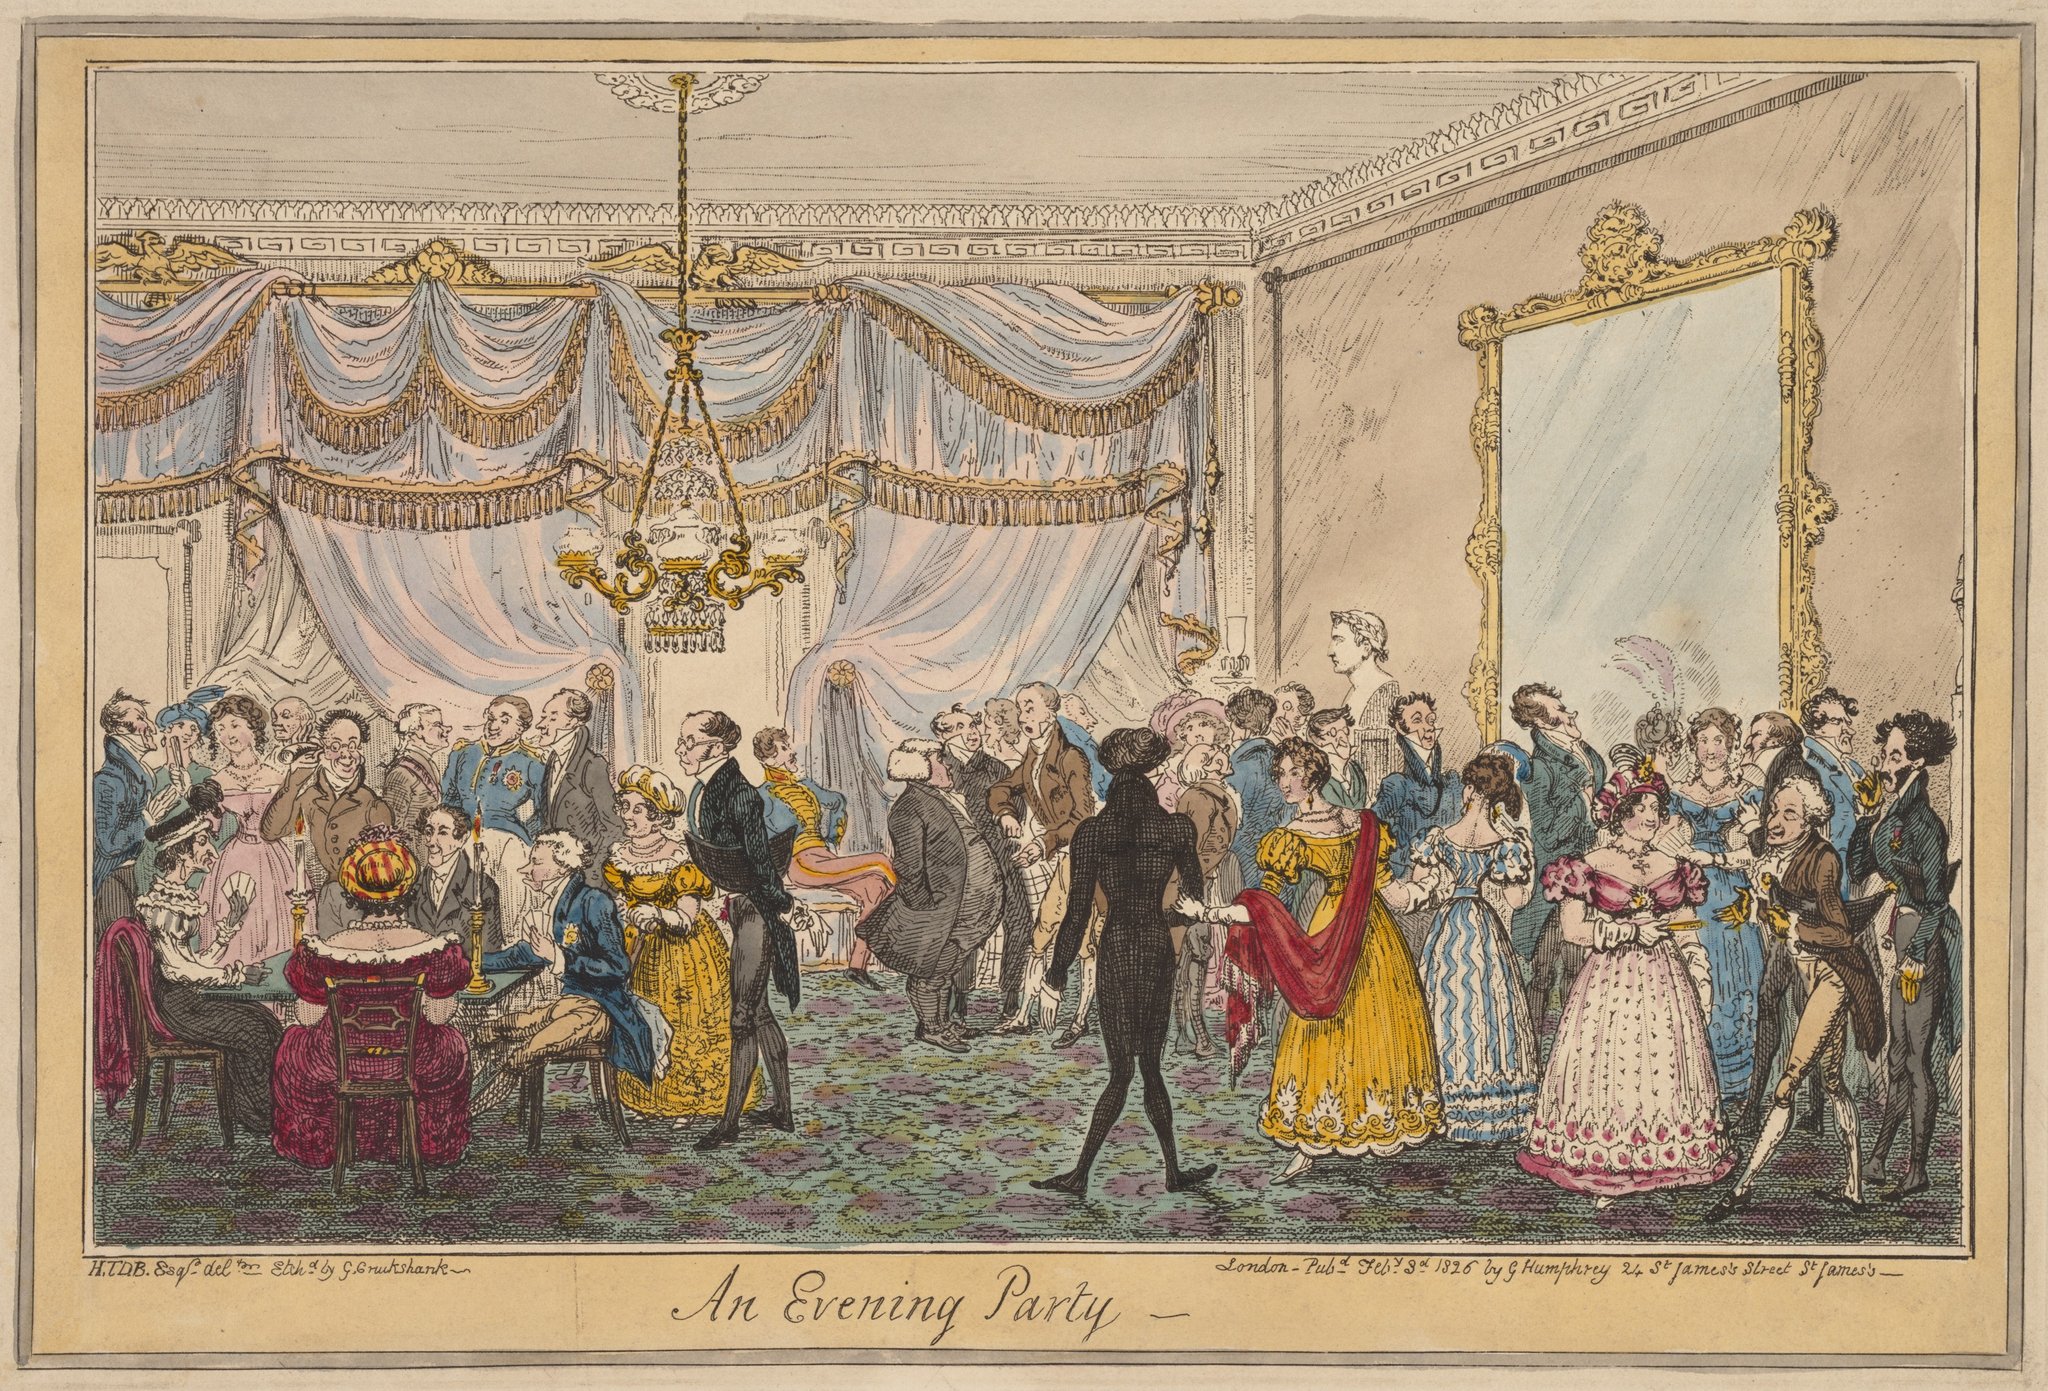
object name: print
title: An Evening Party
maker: george cruikshank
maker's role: artist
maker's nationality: british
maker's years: 1792-1878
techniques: engraving, etching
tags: men,women,party